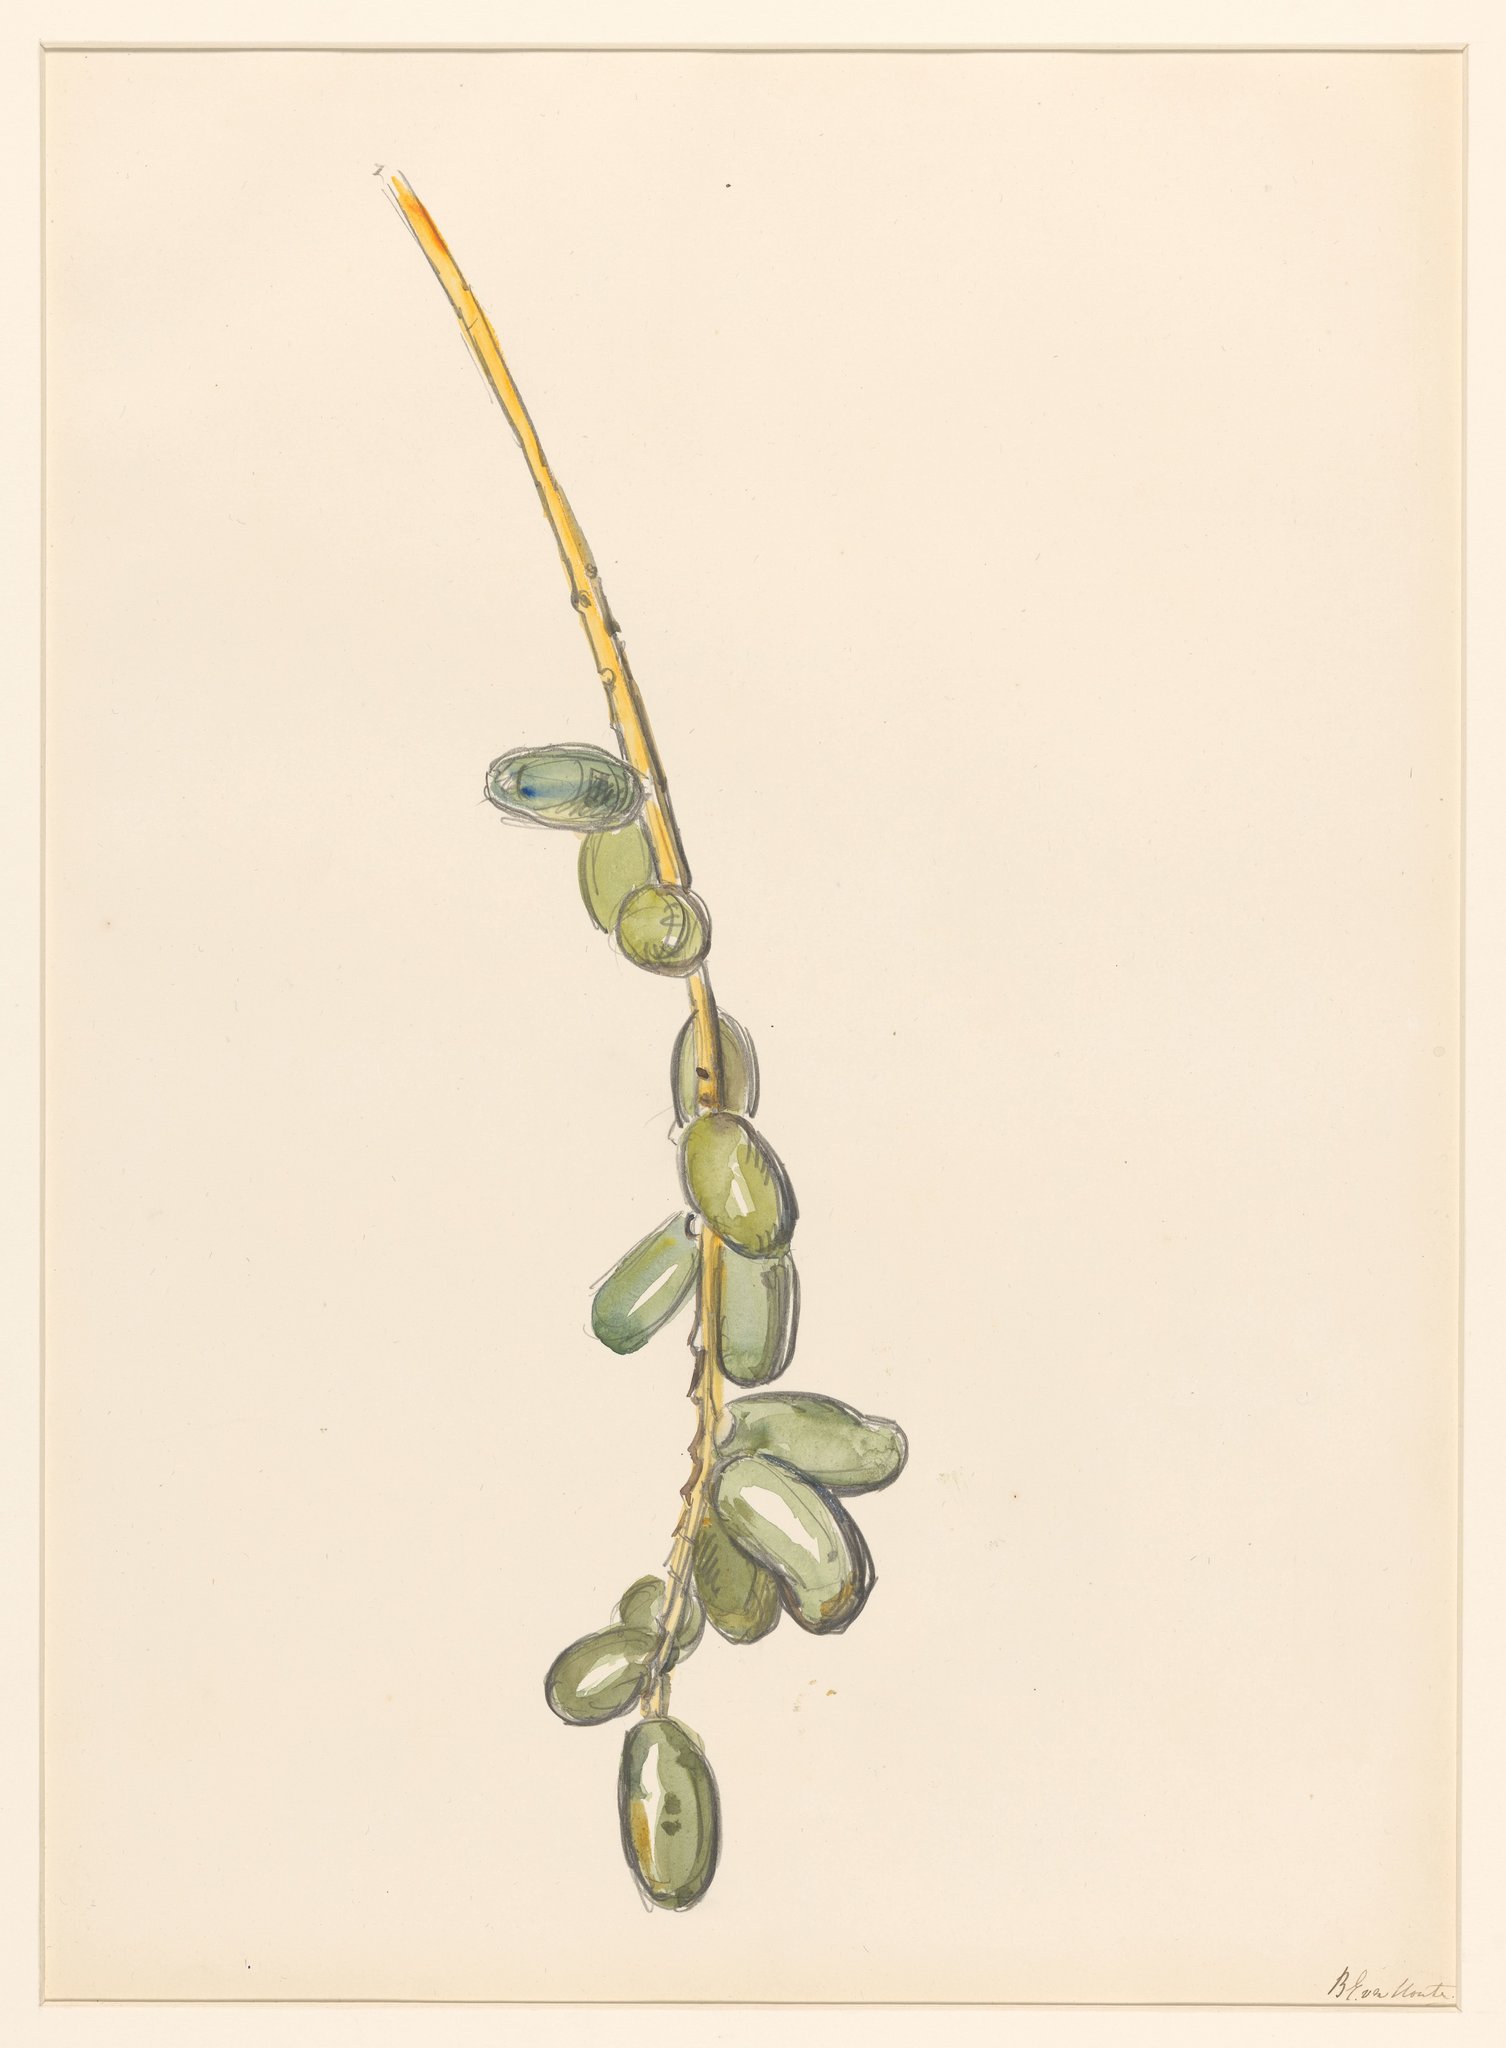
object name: watercolor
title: Takje van een dadelpalm met groene vruchten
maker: barbara elisabeth van houten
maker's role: draughtsman, print maker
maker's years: 1862-1950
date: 1872-1950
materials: paper, pencil, watercolor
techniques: brush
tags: fruits: date